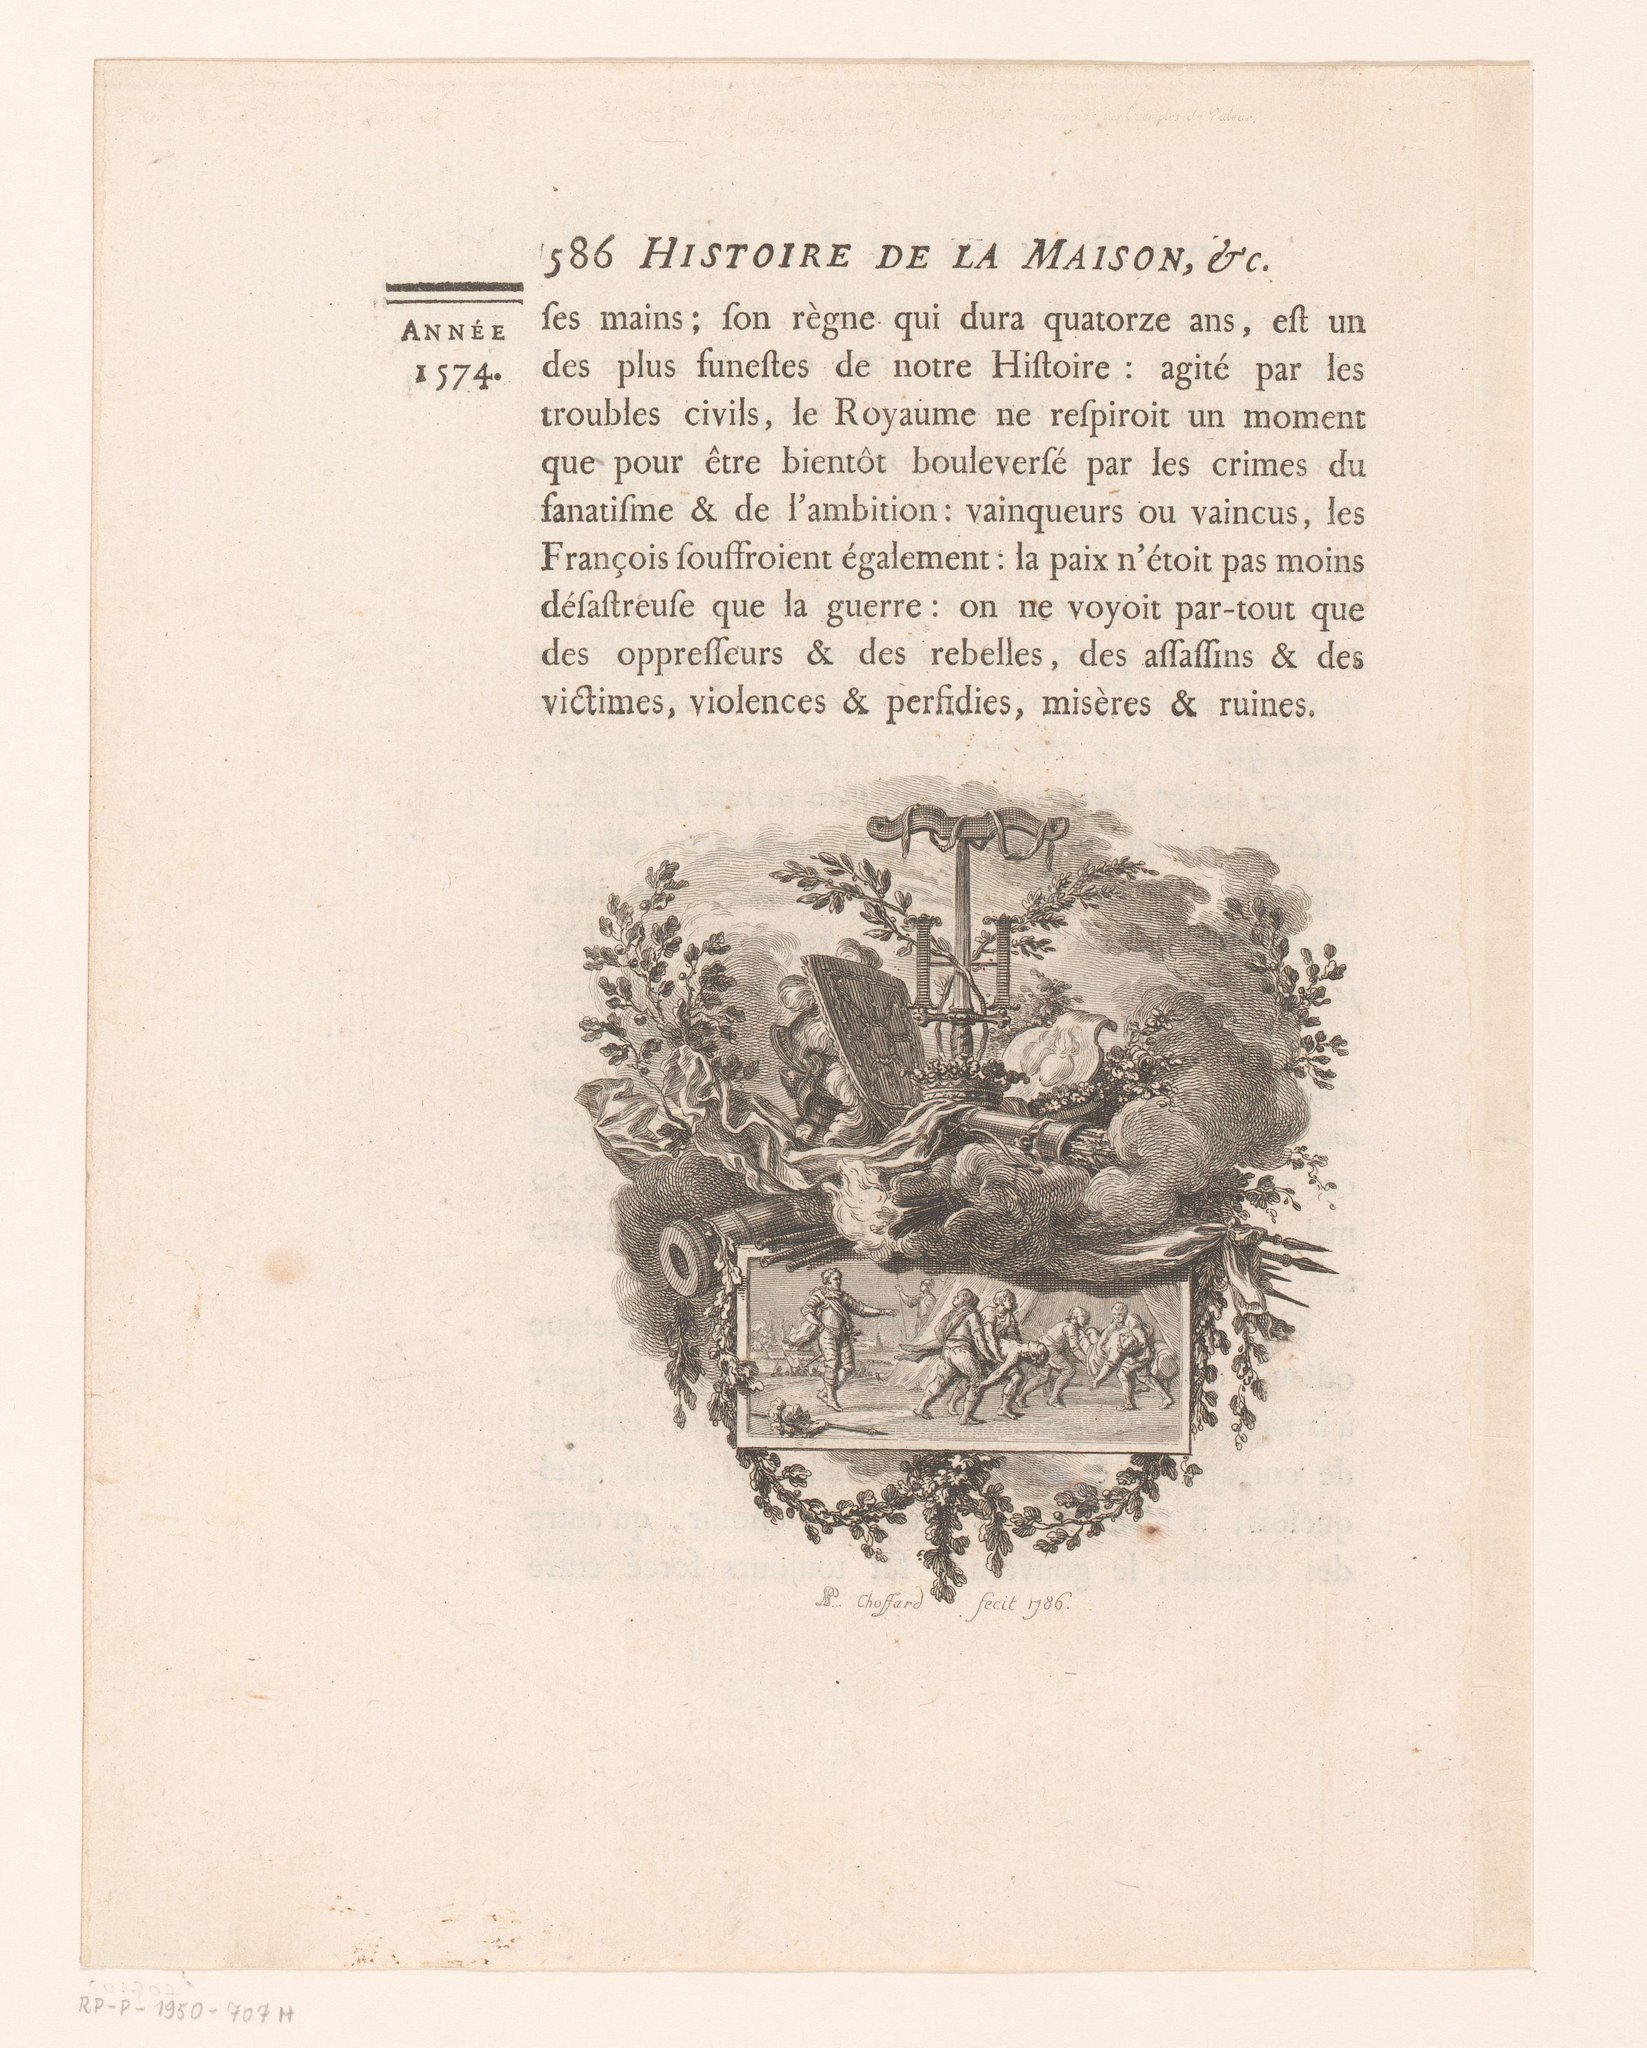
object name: book illustration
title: Allegorische voorstelling met schild, pijlen en fries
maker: pierre philippe choffard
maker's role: print maker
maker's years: 1730-1809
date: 1786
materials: paper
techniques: engraving, etching, letterpress printing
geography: france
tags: helmet, protective weapons: shield, carrying the sick, wounded and dead off the battle-field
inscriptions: collector's mark: Lugt 2228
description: Prent uit: Désormeaux, Joseph-Louis-Ripault. Histoire de la maison de Bourbon. Parijs: L'imprimerie royale, 1786, dl. 4, p. 586.